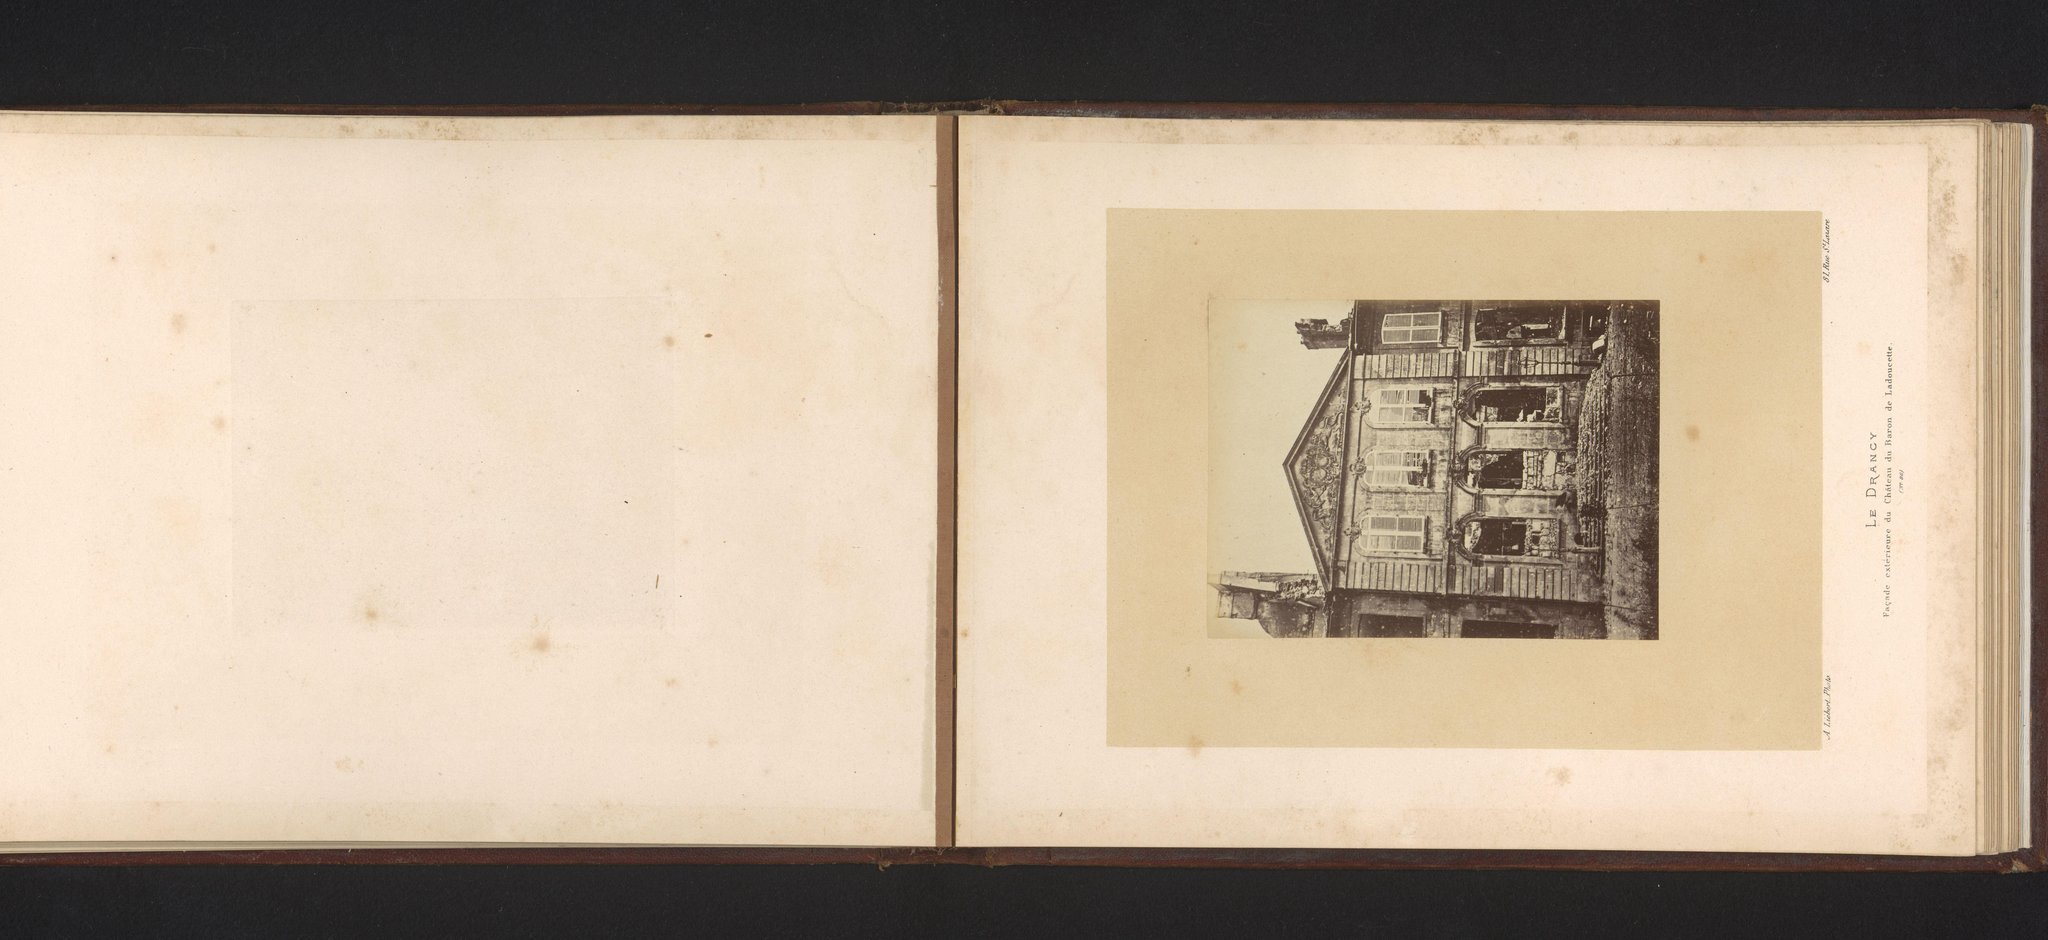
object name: page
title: Le Drancy. Façade extérieure du Château du Baron de Ladoucette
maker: alphonse-justin liébert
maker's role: fotograaf, marinier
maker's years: 1827-1914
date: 1871-1872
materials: photographic support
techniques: albumen print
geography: drancy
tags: ruin of a building ~ architecture, villa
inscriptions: number: ‘(No. 86)’, address: ‘31, Rue St. Lazare’